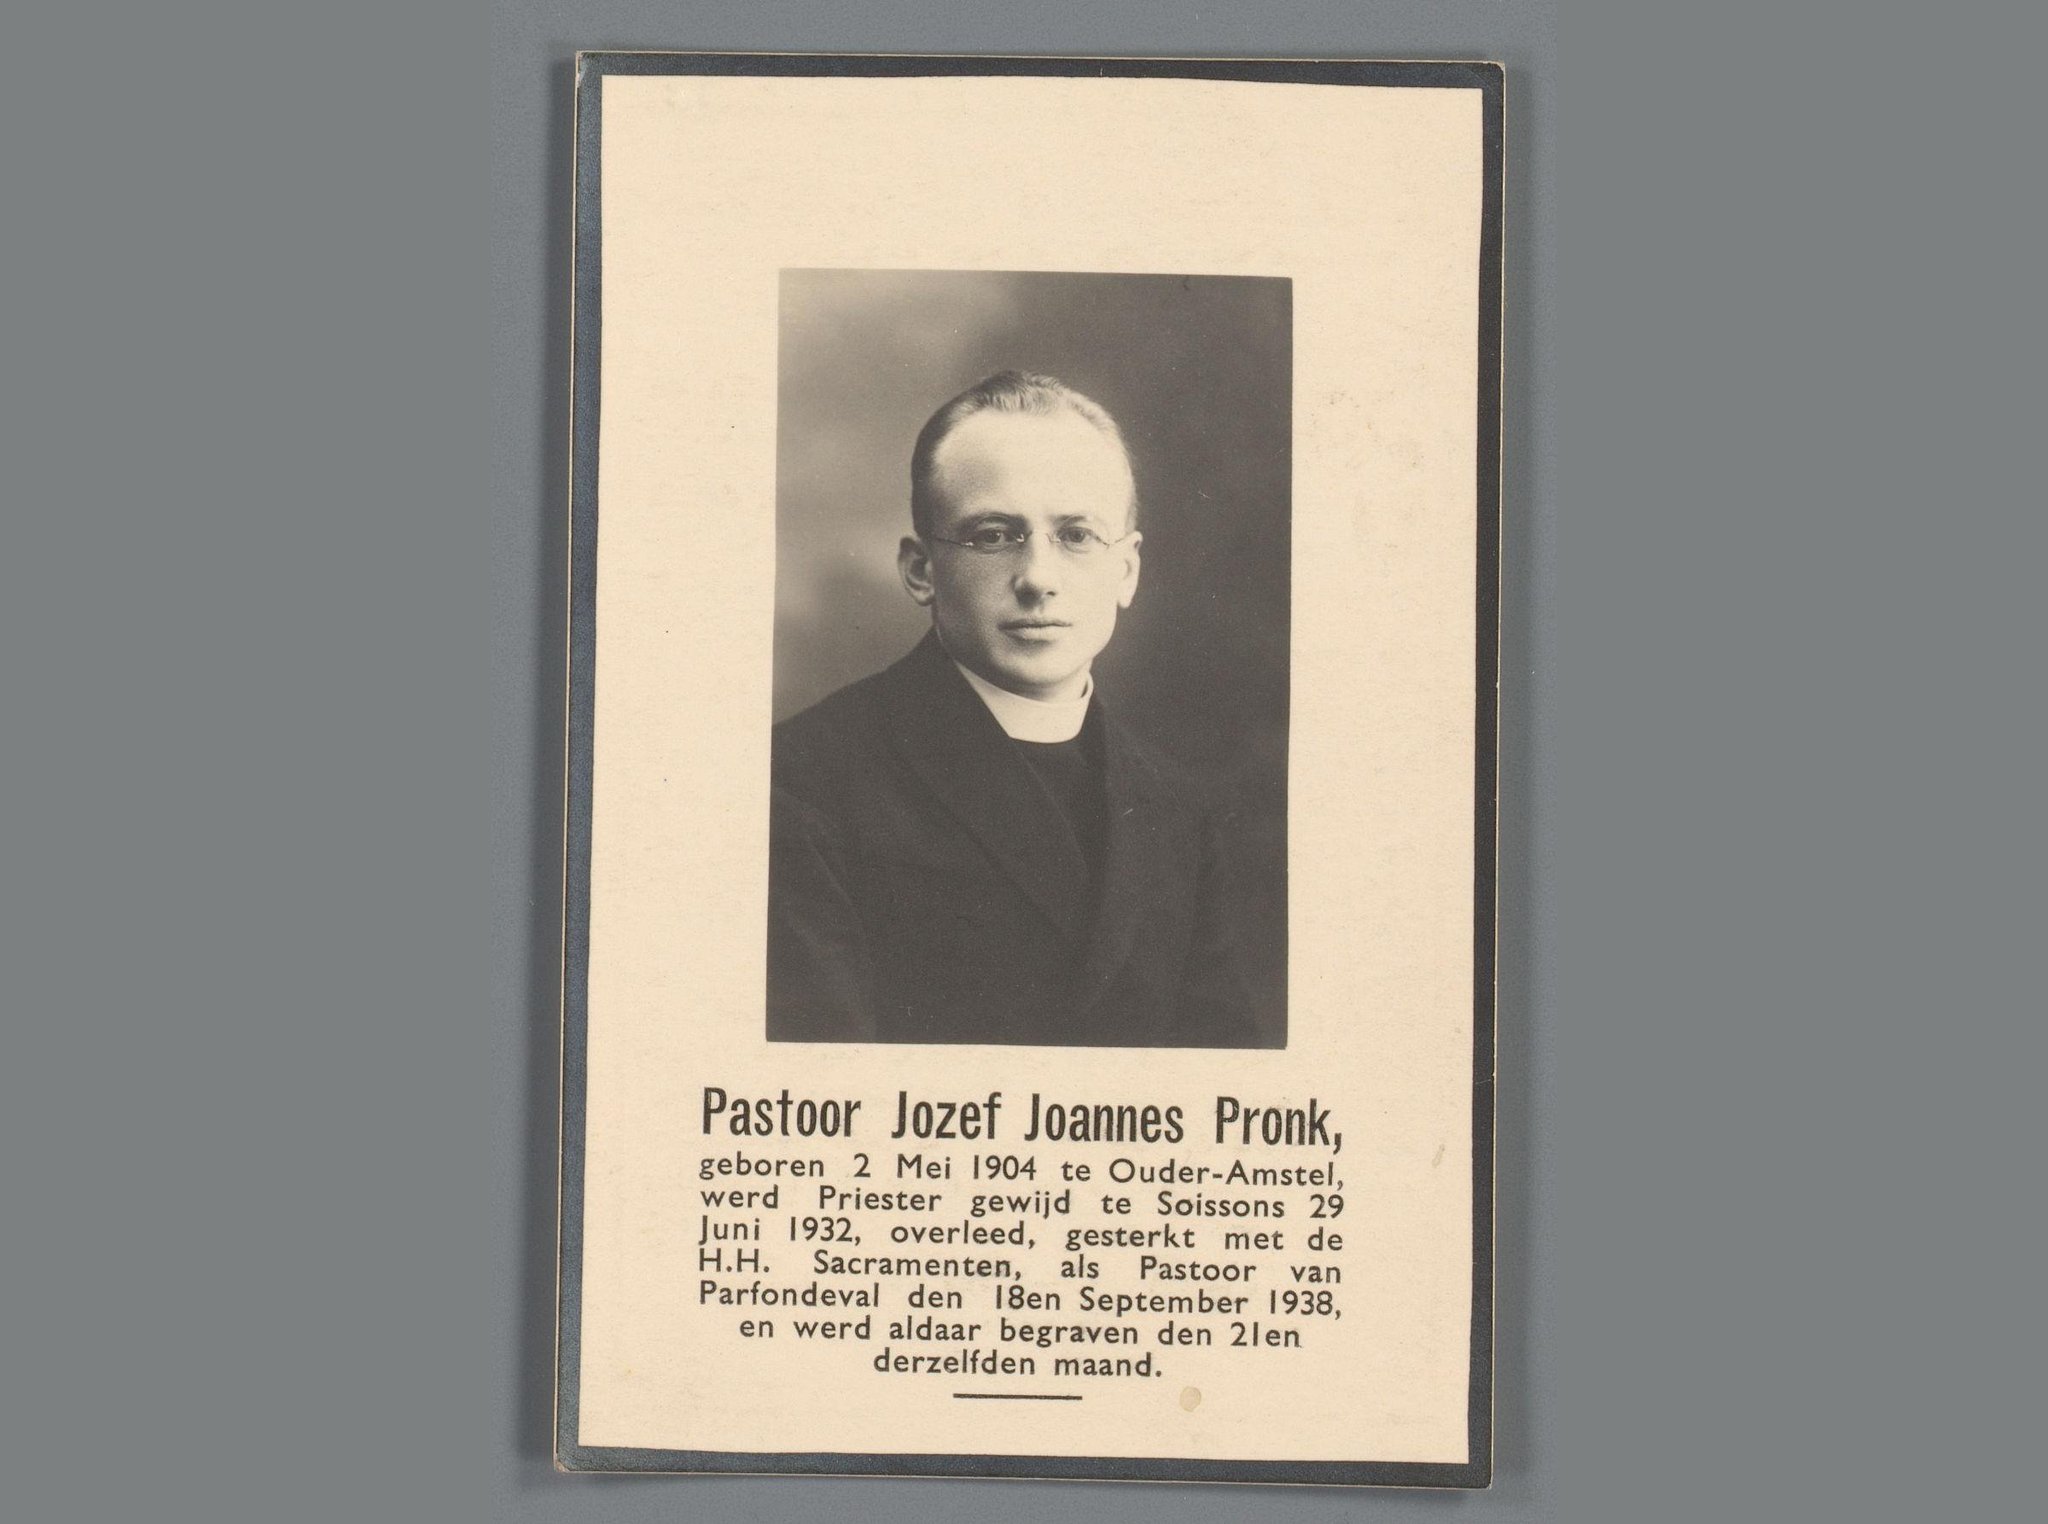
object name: prayer card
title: Portret van Jozef Joannes Pronk op bidprent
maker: Anonymous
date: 1938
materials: paper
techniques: gelatin silver print, letterpress printing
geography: soissons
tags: priest (roman catholic), historical persons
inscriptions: inscription: ‘In het H. Misoffer, de gebeden en goede (...) Onze Vader - Wees gegroet./ In pace.’, inscription: ‘Pastoor Jozef Joannes Pronk, (...) derzelfden maand.’